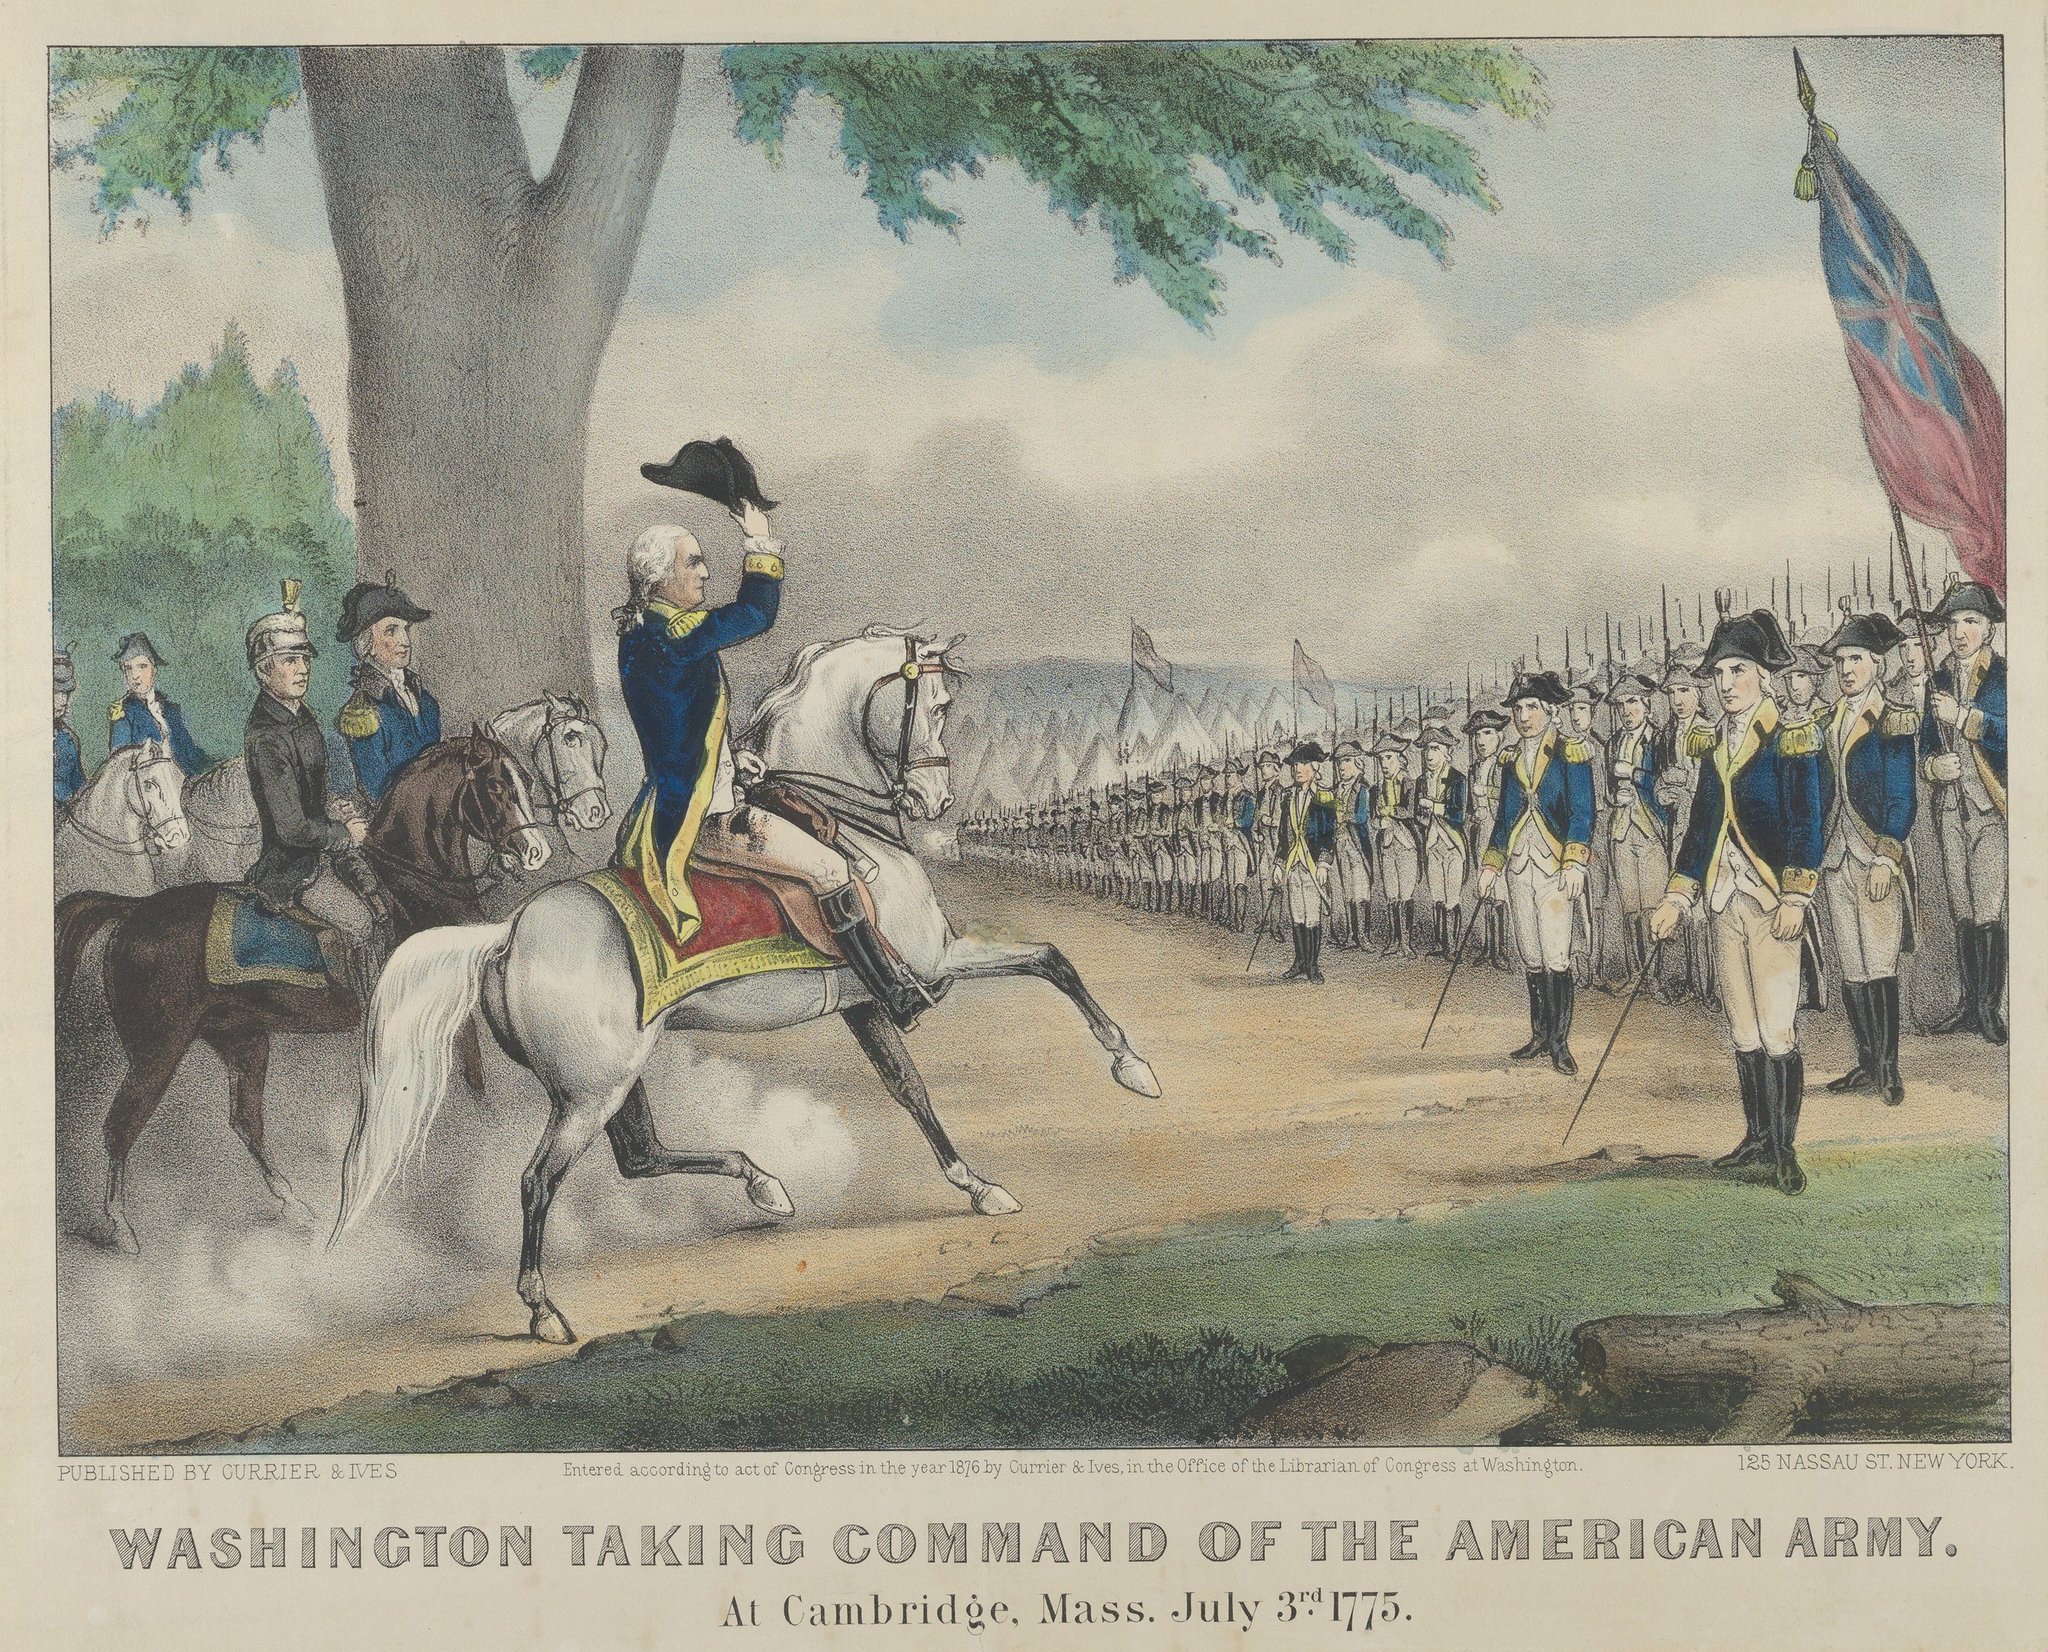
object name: print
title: Washington Taking Command of the American Army – At Cambridge, Massachusetts, July 3rd, 1775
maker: currier & ives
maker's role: publisher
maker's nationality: american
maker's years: 1857-1907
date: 1876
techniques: hand coloring, lithograph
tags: army,george washington,men,horses,flags